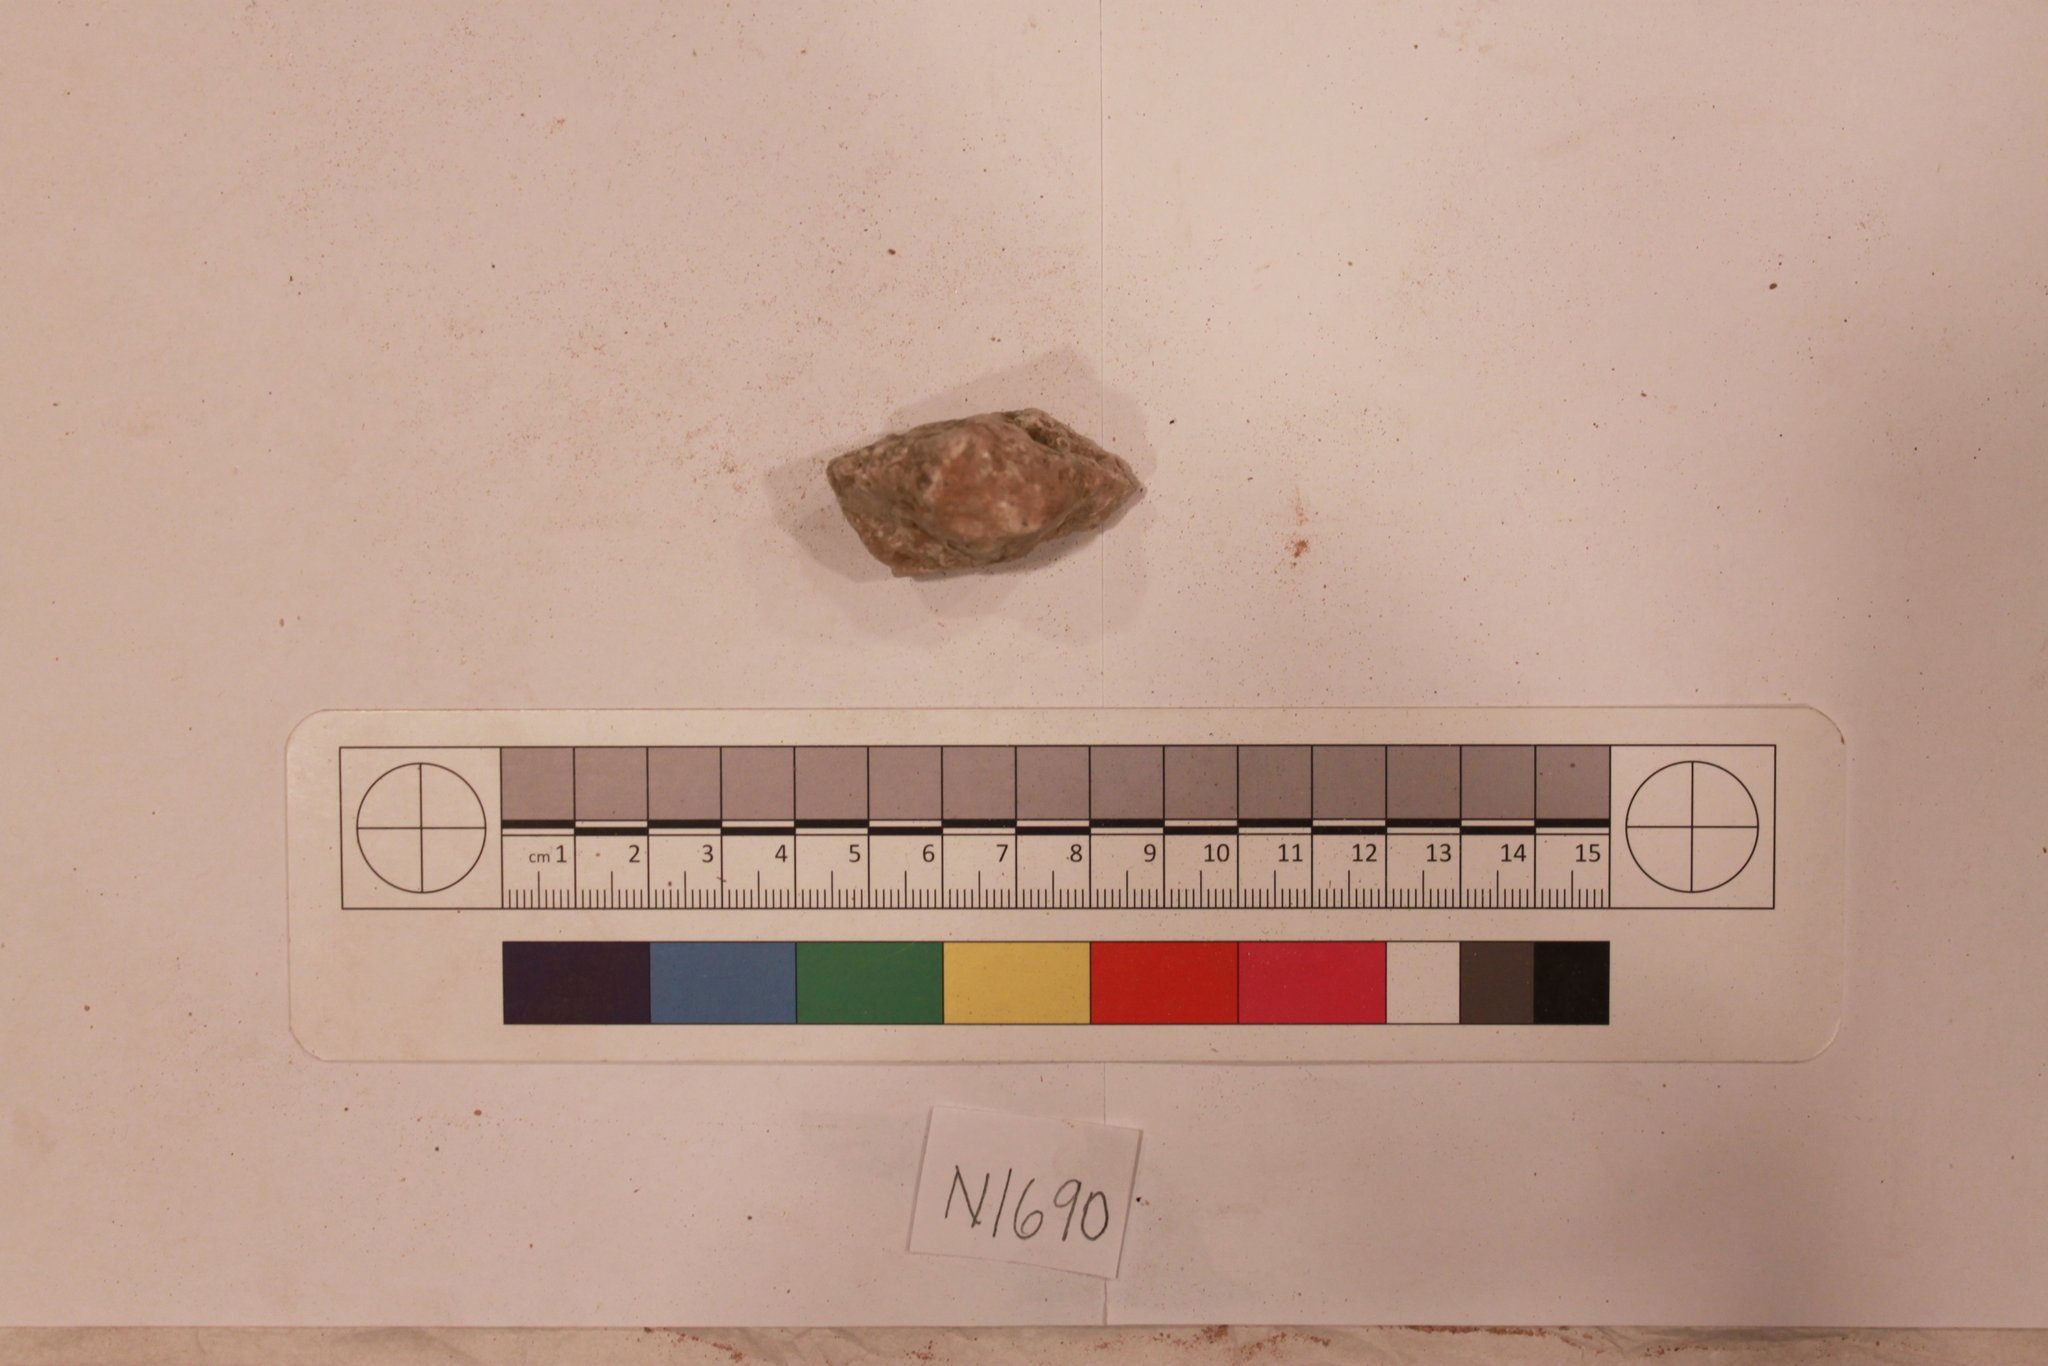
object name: fragment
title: Stucco Fragment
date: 701-1200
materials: plaster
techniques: carving, painting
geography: iran